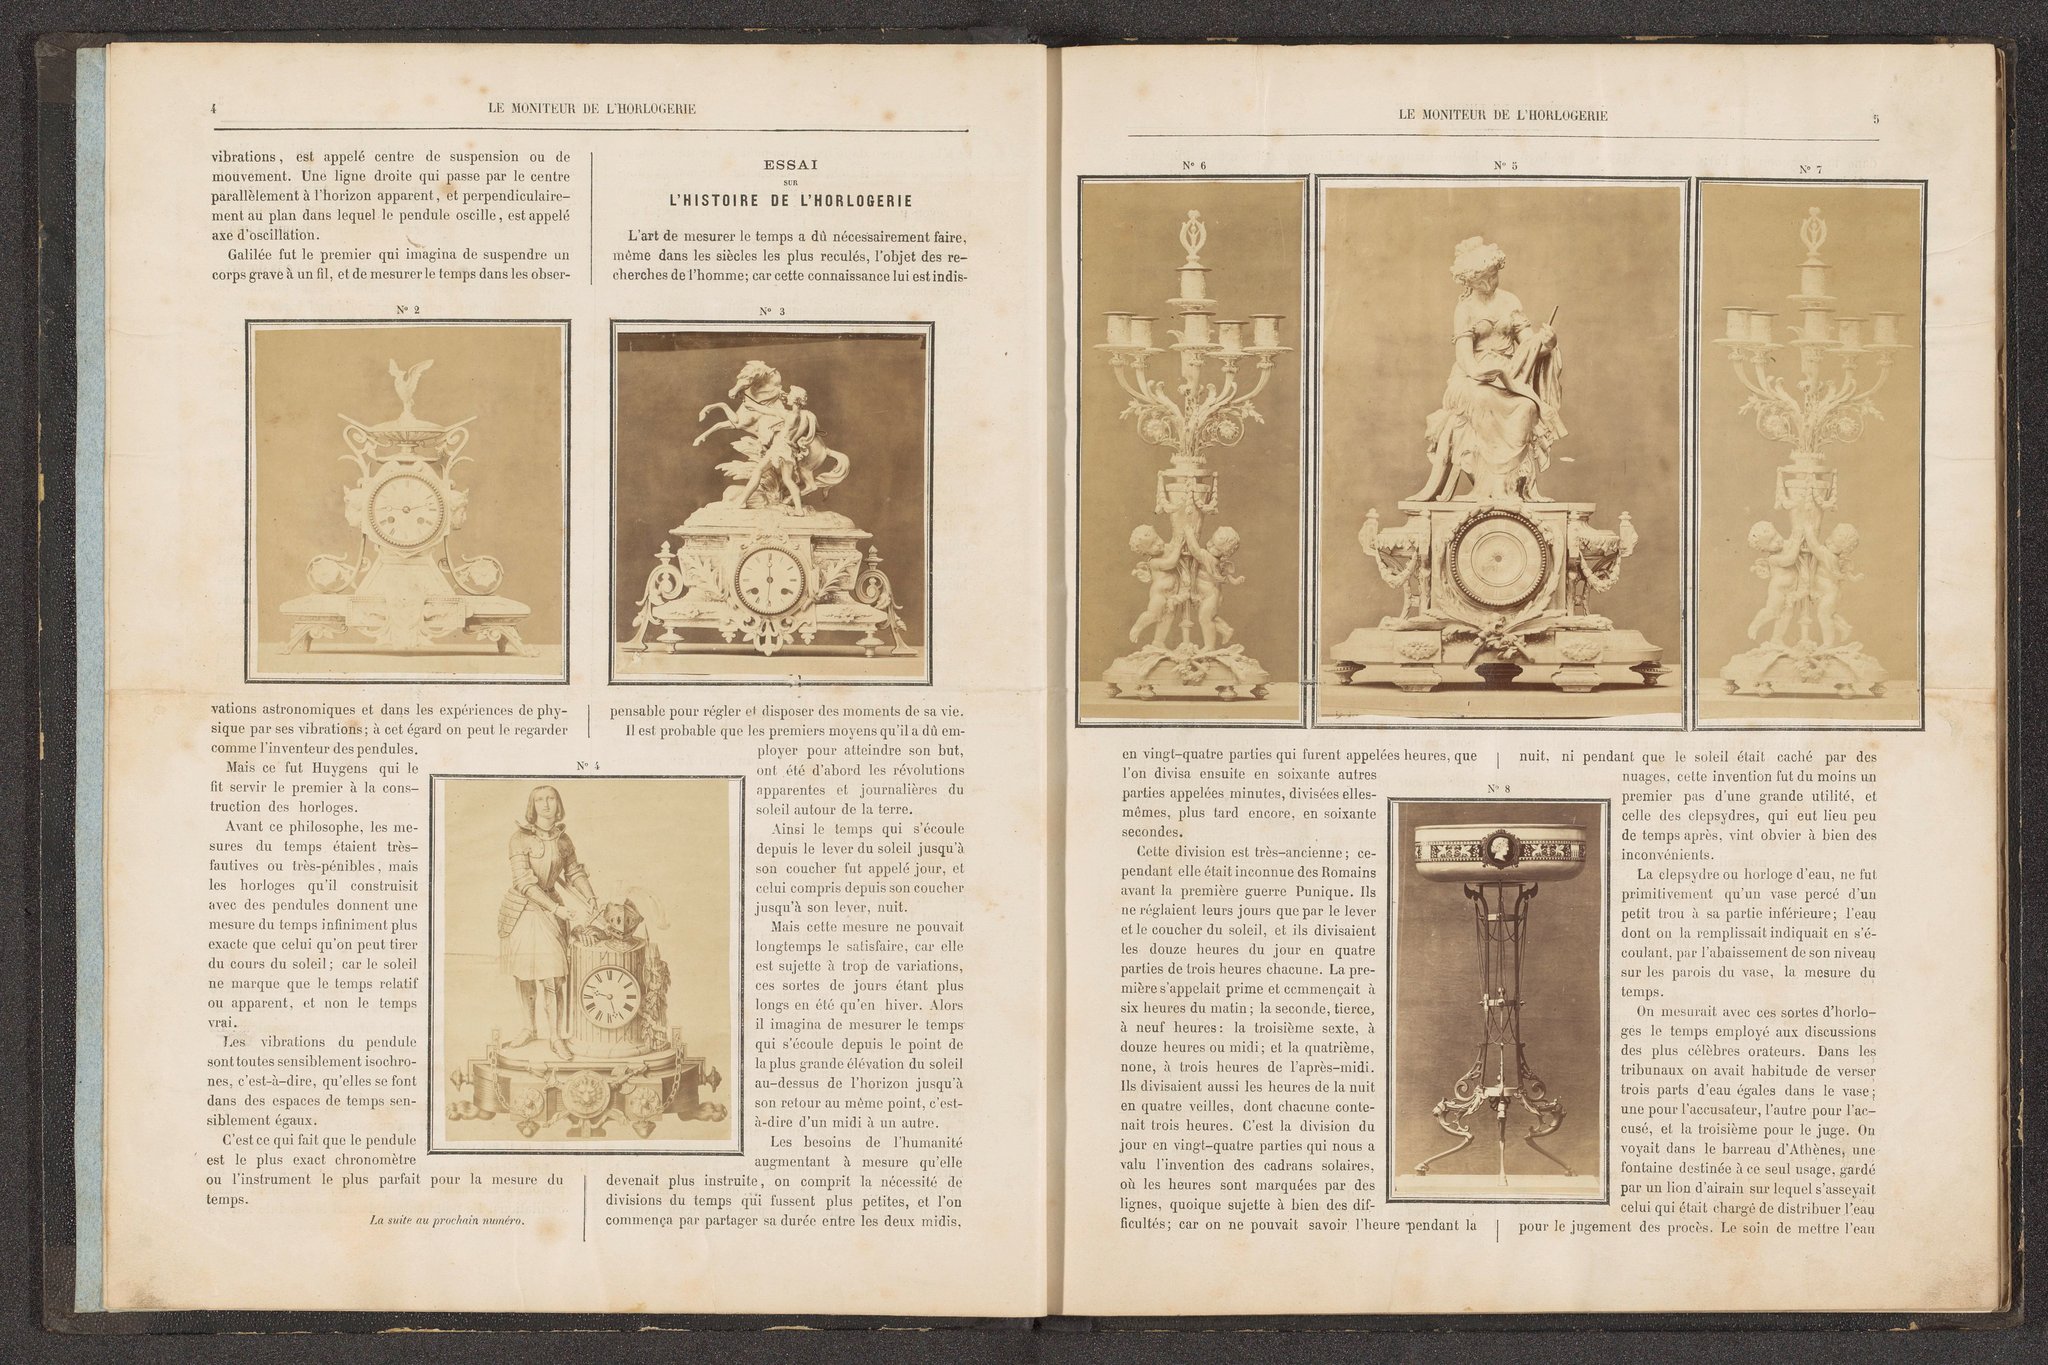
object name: reproduction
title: Twee klokken en een fotoreproductie van een prent van een klok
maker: Anonymous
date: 1857-1867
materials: photographic support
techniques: albumen print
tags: print, e.g.: engraving, etching, lithograph, clock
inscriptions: number: ‘No 2 No 3 No 4’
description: Boven: klok gedecoreerd met een vogel en een klok gedecoreerd met een man en een paard door maison Lebrun, onder: een prent van Jeanne d'Arc naast een klok in de vorm van een pilaar.